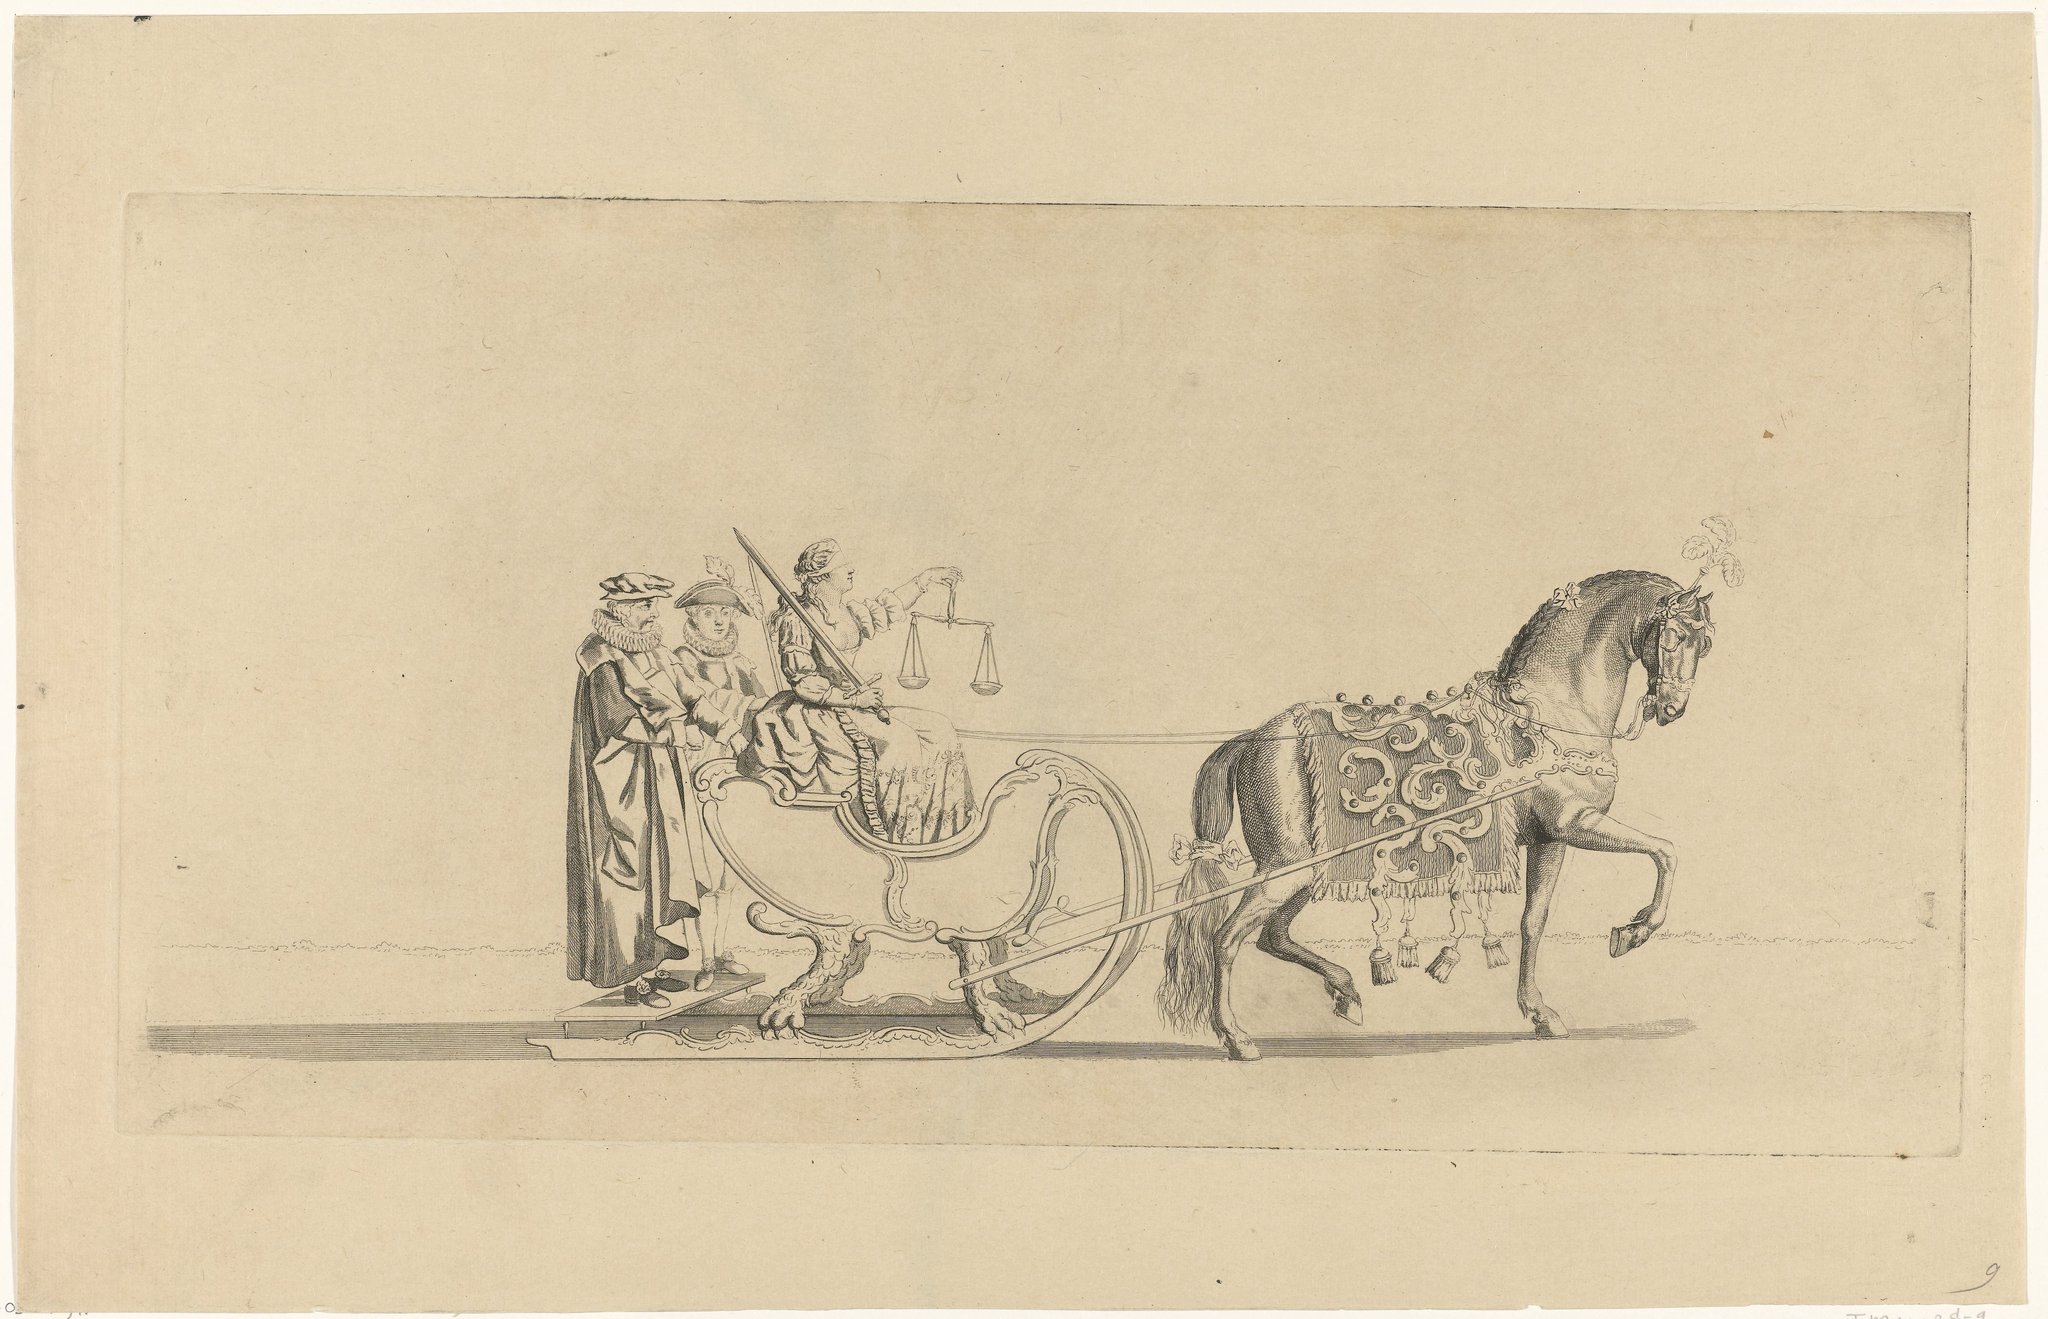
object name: print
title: Negende slede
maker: nicolaas van der worm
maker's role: draughtsman, print maker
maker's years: 1757-1828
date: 1776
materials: paper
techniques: etching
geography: northern netherlands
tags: justice, 'justitia'; 'giustitia divina' (ripa) ~ one of the four cardinal virtues, sledge, sleigh (winter sports), commemoration of the founding of a university, leiden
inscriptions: collector's mark: Lugt 240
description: De negende slede in de optocht. Een slede met de personificatie van de Rechtvaardigheid, getrokken door een paard. Onderdeel van een reeks van twaalf platen (etsdruk vóór het nummer en op ander papier) van de sledevaart op 24 januari 1776 georganiseerd door het Leidse genootschap Veniam Pro Laude bij gelegenheid van het Tweede Eeuwfeest van het Leids Ontzet (3 oktober 1574) en de oprichting van de Universiteit van Leiden (8 februari 1575).